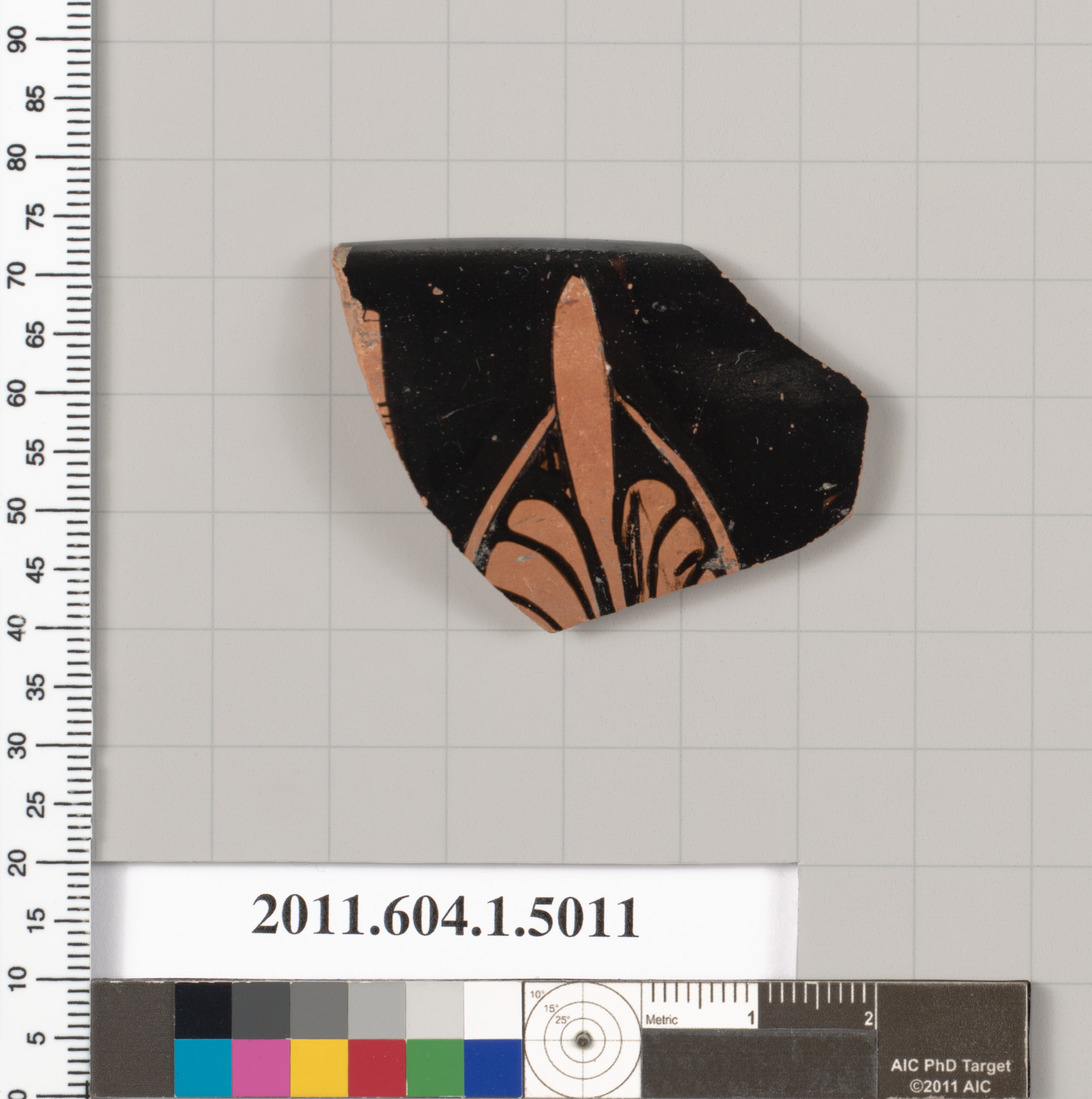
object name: kylix fragment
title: Terracotta rim fragment of a kylix (drinking cup)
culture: greek, attic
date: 475-451 BCE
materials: terracotta